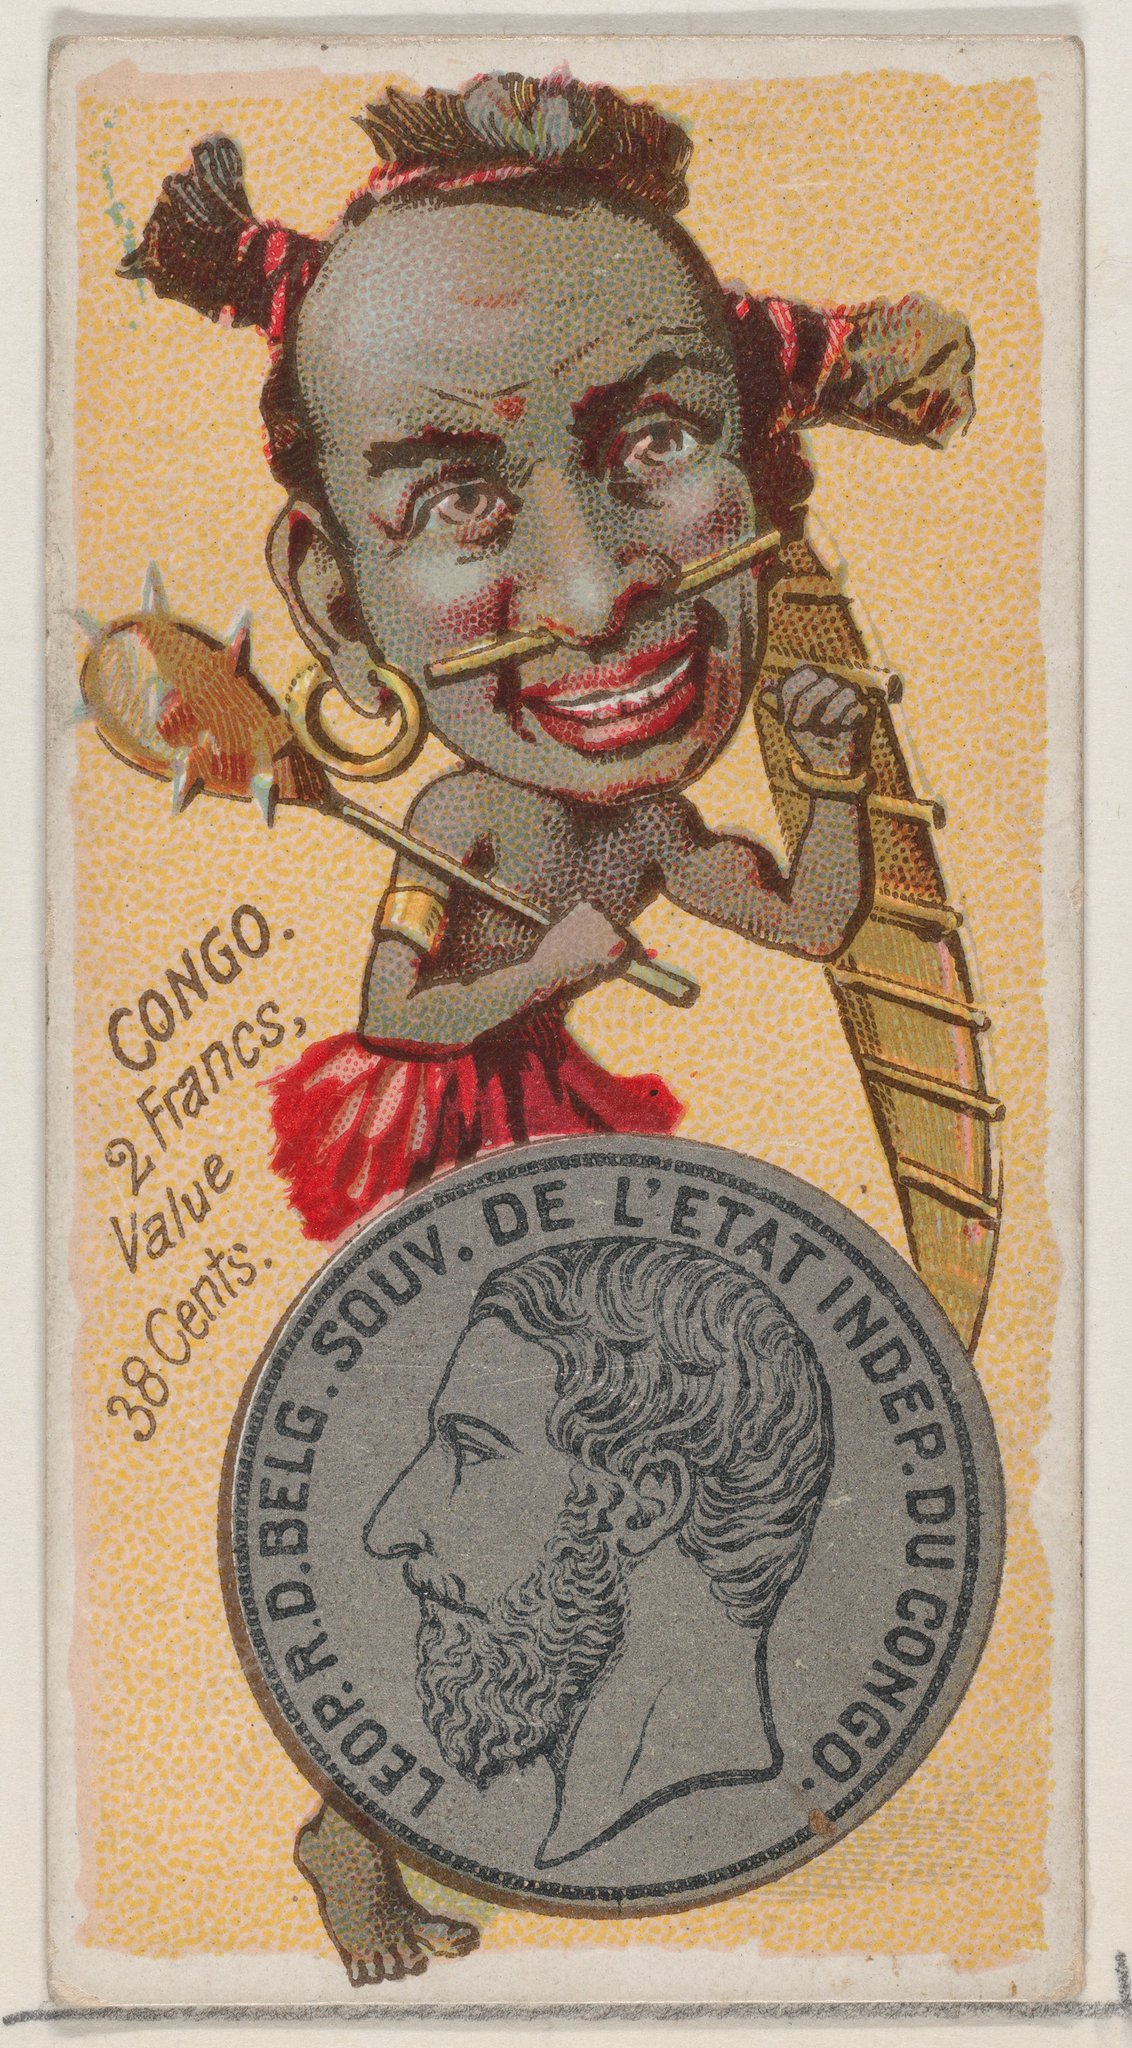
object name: print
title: Caricatured figure from the Congo, 2 Francs, from the series Coins of All Nations (N72, variation 2) for Duke brand cigarettes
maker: w. duke, sons & co.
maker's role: publisher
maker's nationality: american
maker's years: 1870-1920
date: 1889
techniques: color lithograph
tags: men,coins